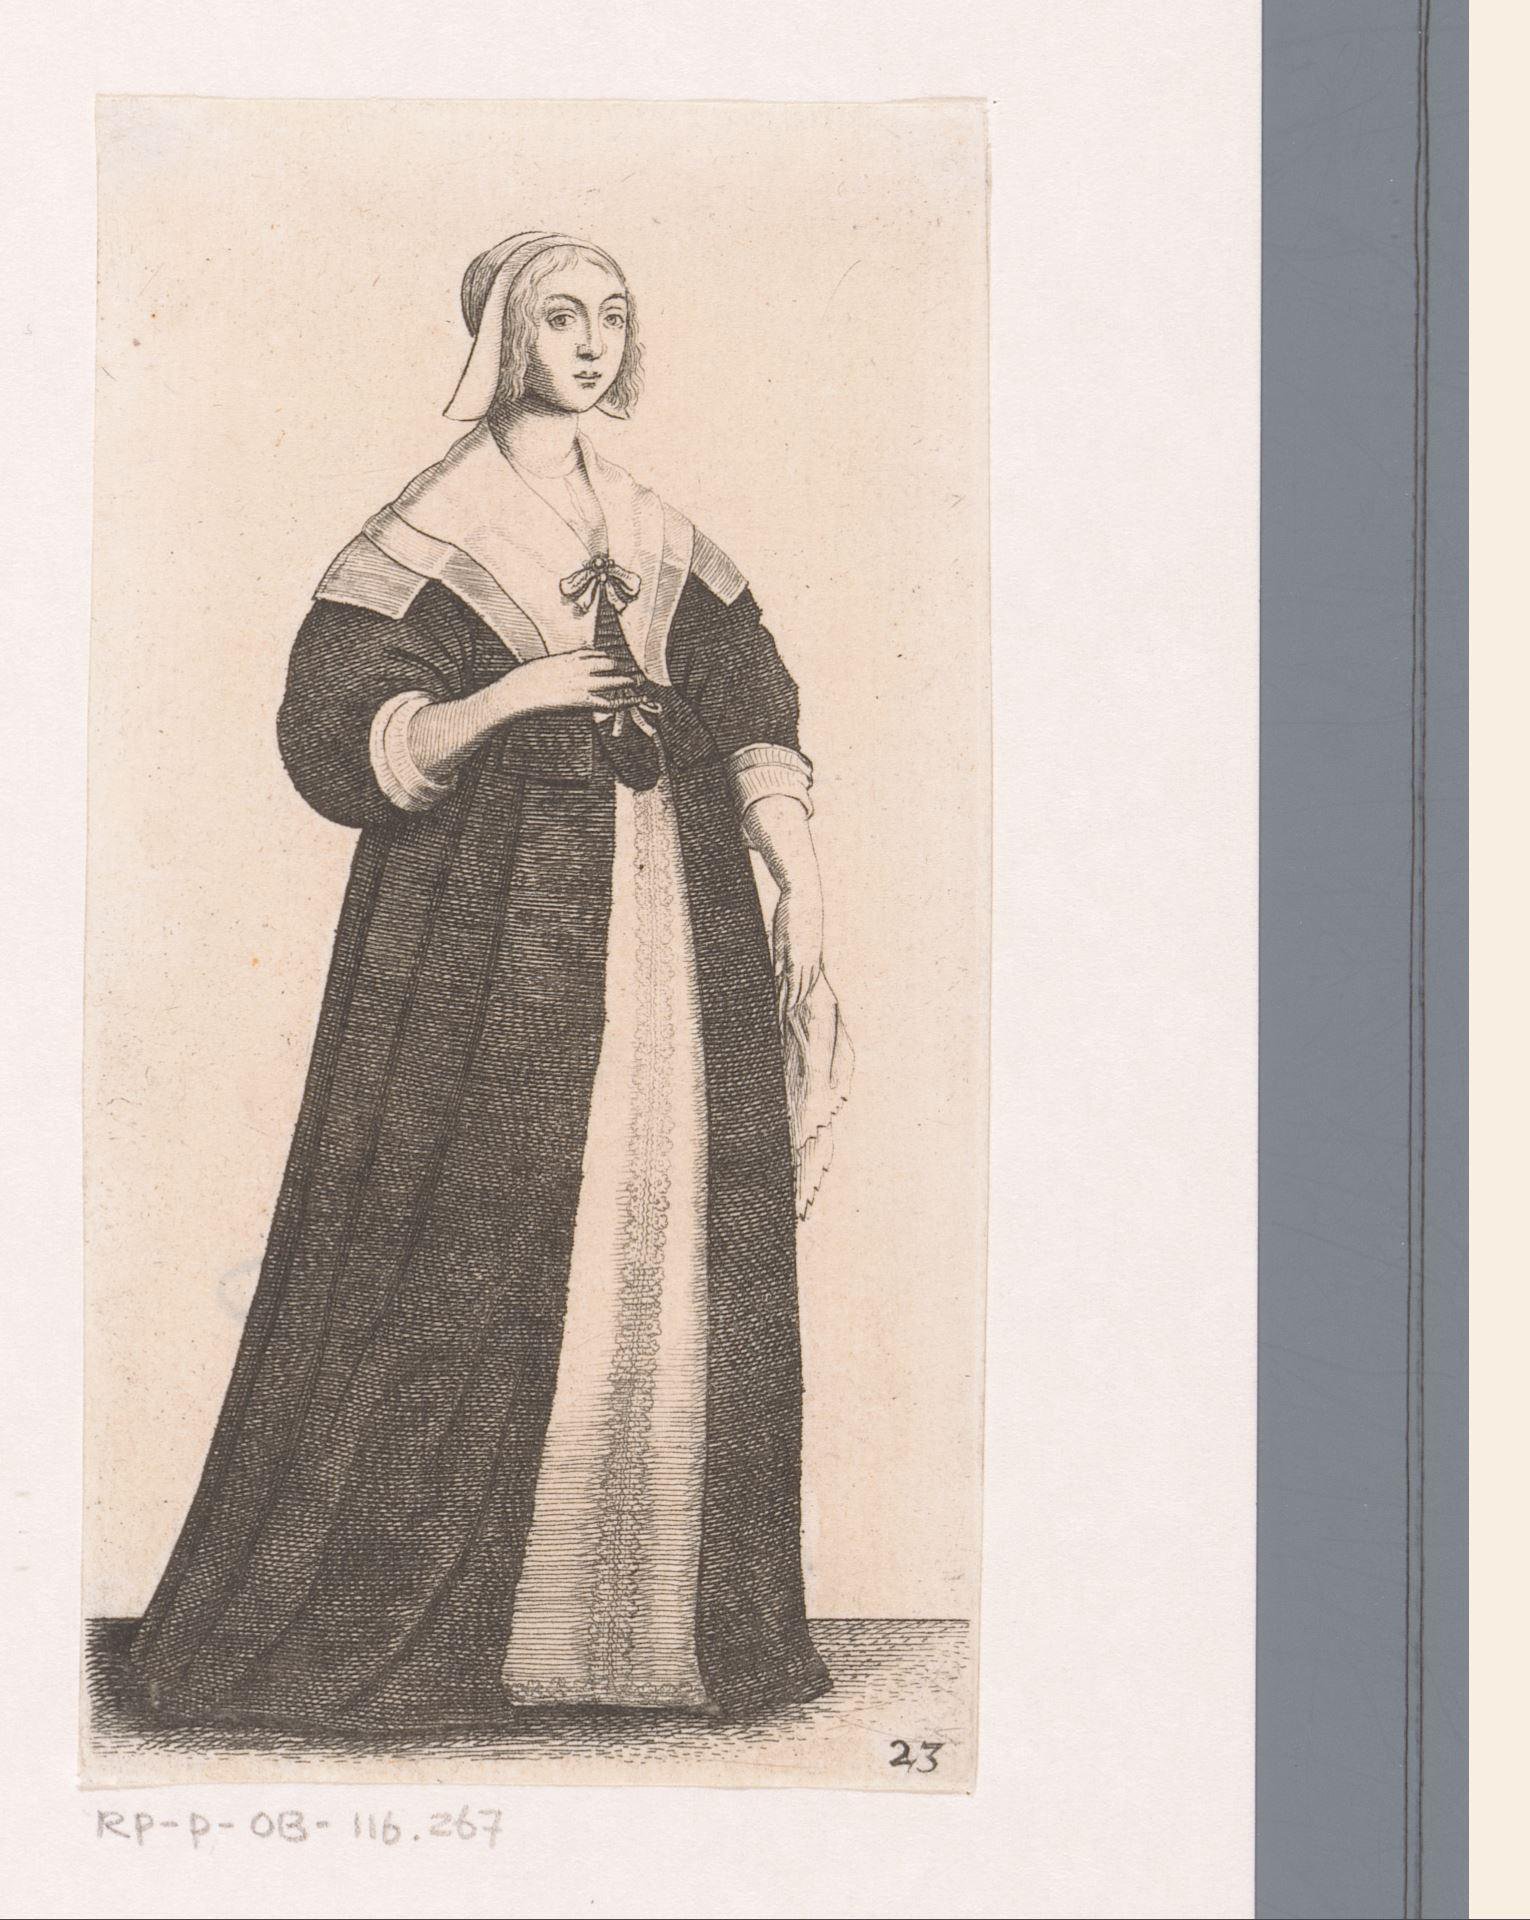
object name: costume print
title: Ornatus Muliebris Anglicanus / The Severall Habits of English Women, from the Nobilitie to the contry woman, they are in these times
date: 1640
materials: paper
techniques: etching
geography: london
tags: bow (ornamental part of clothing) (+ women's clothes), neck-gear ~ clothing (neckerchief) (+ women's clothes), europeans: englishmen (+ women), head-gear: cap (+ women's clothes), fashion, clothing (+ lace used for clothes), neck-gear: collar (+ women's clothes), fashion plates, clothes, costume (+ women's clothes), handkerchief, dress, gown (+ women's clothes), clothes, costume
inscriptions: collector's mark: Lugt 2228, collector's mark: Lugt 2760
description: Engelse vrouw met een mutsje met een teruggeslagen rand bij het voorhoofd en die aan weerszijden van het gezicht toeloopt en naar buiten uitstaat. Over de schouders een dubbelgevouwen onversierde, transparante halsdoek, die middenvoor gesloten wordt met een sieraad en een strik. De onderrok is middenvoor versierd met twee verticaal, tegen elkaar geplaatste geschulpte stroken kant of passement. Een zakdoek in haar linkerhand.